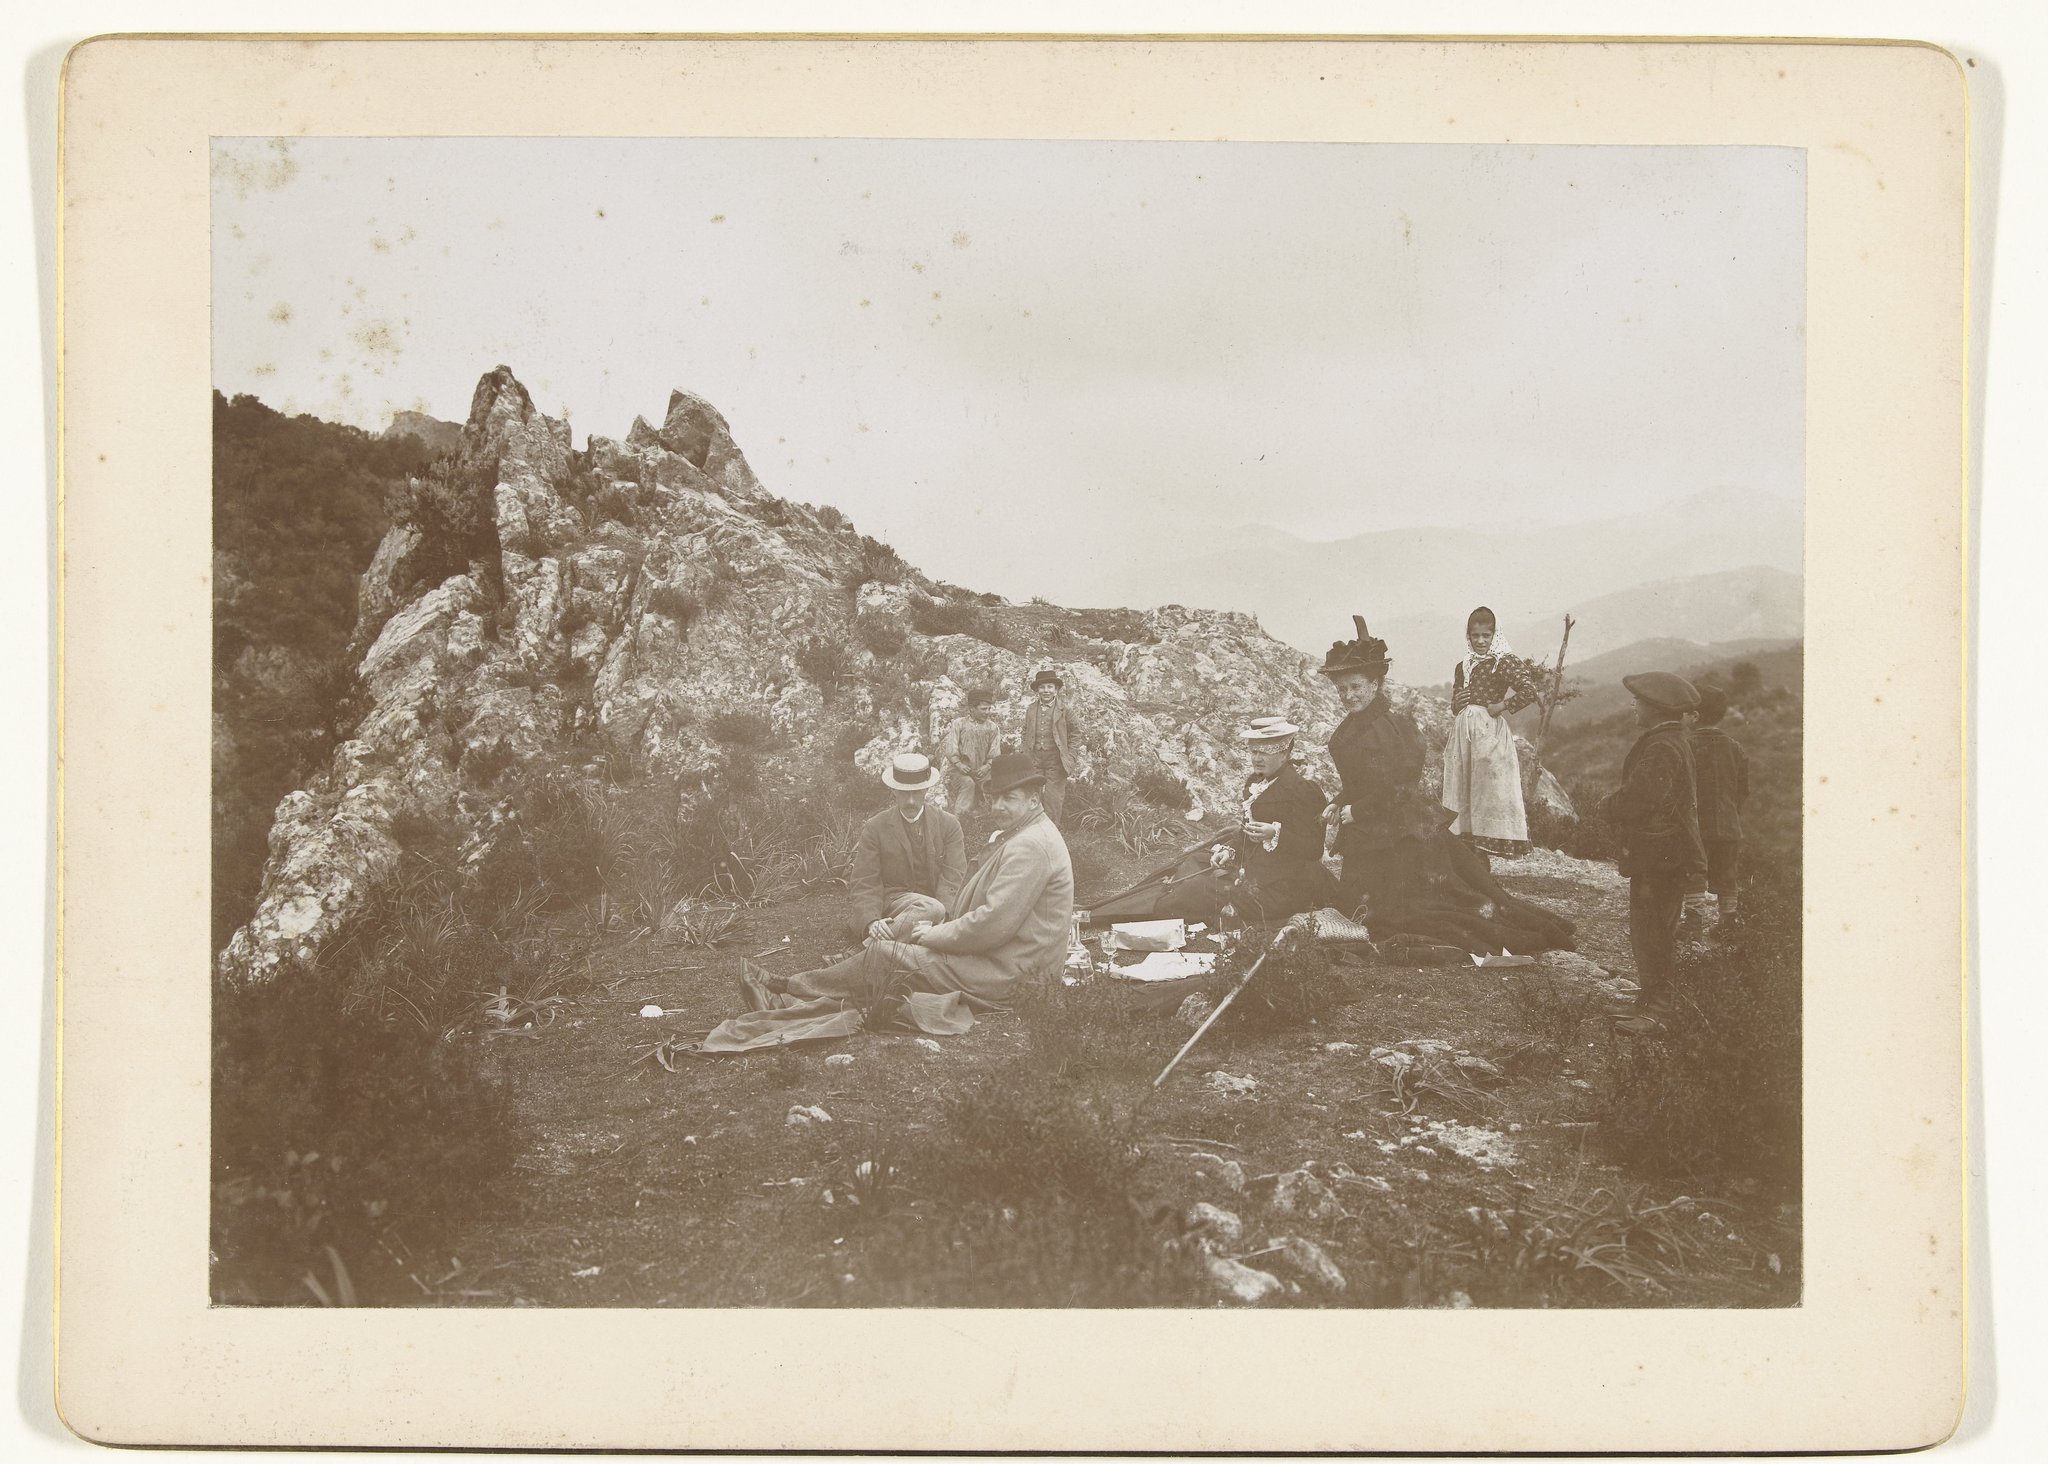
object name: photograph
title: Groepsportret van reizigers en helpers tijdens een picknick in de bergen, in Frankrijk of Italië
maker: henry pauw van wieldrecht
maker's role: fotograaf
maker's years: 1863-1912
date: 1896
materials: cardboard, photographic support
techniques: gelatin silver print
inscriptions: annotation: ‘No. 1165. 1896.’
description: Een van de mannen is Maarten of Henry Pauw van Wieldrecht.